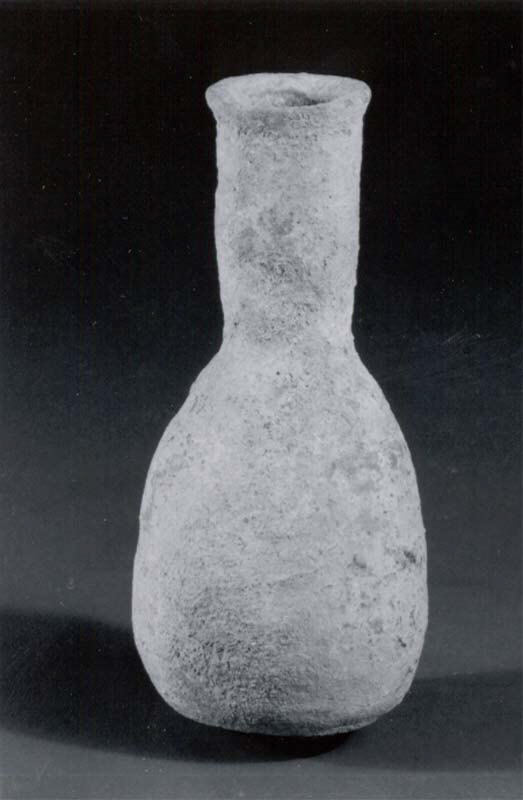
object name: vessel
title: Unguentarium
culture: nabataean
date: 1-100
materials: ceramic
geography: levant